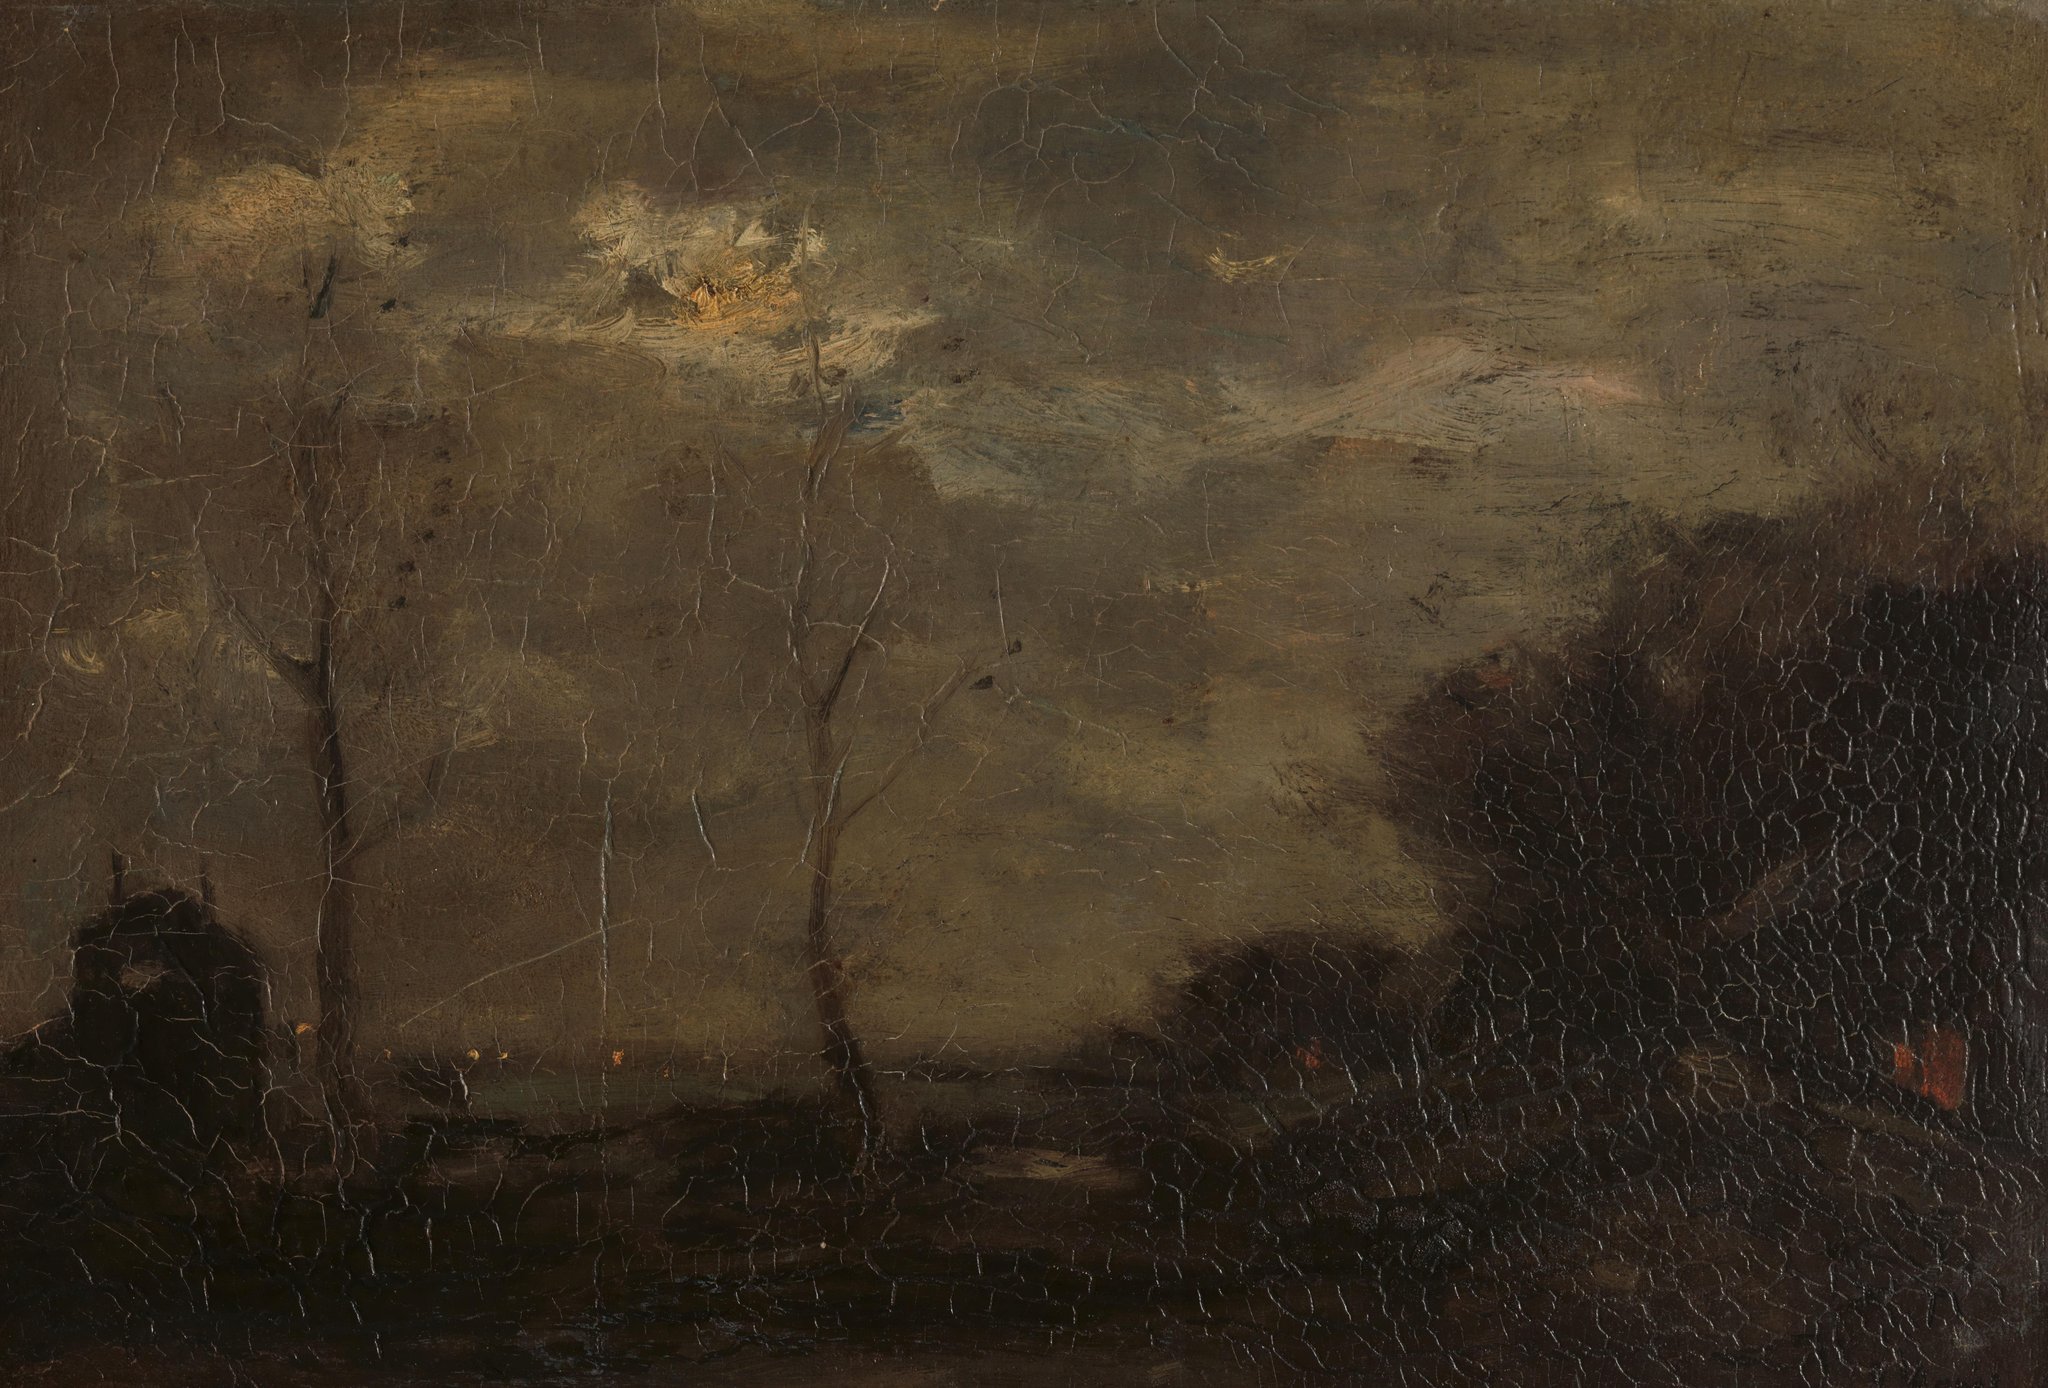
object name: painting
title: Vaart bij maanlicht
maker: jacob maris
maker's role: draughtsman, painter, print maker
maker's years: 1837-1899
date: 1882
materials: canvas, oil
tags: moonlight, water course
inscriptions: signature: ‘J Maris’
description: Landschap met een vaart, enkele bomen en huizen bij maanlicht.